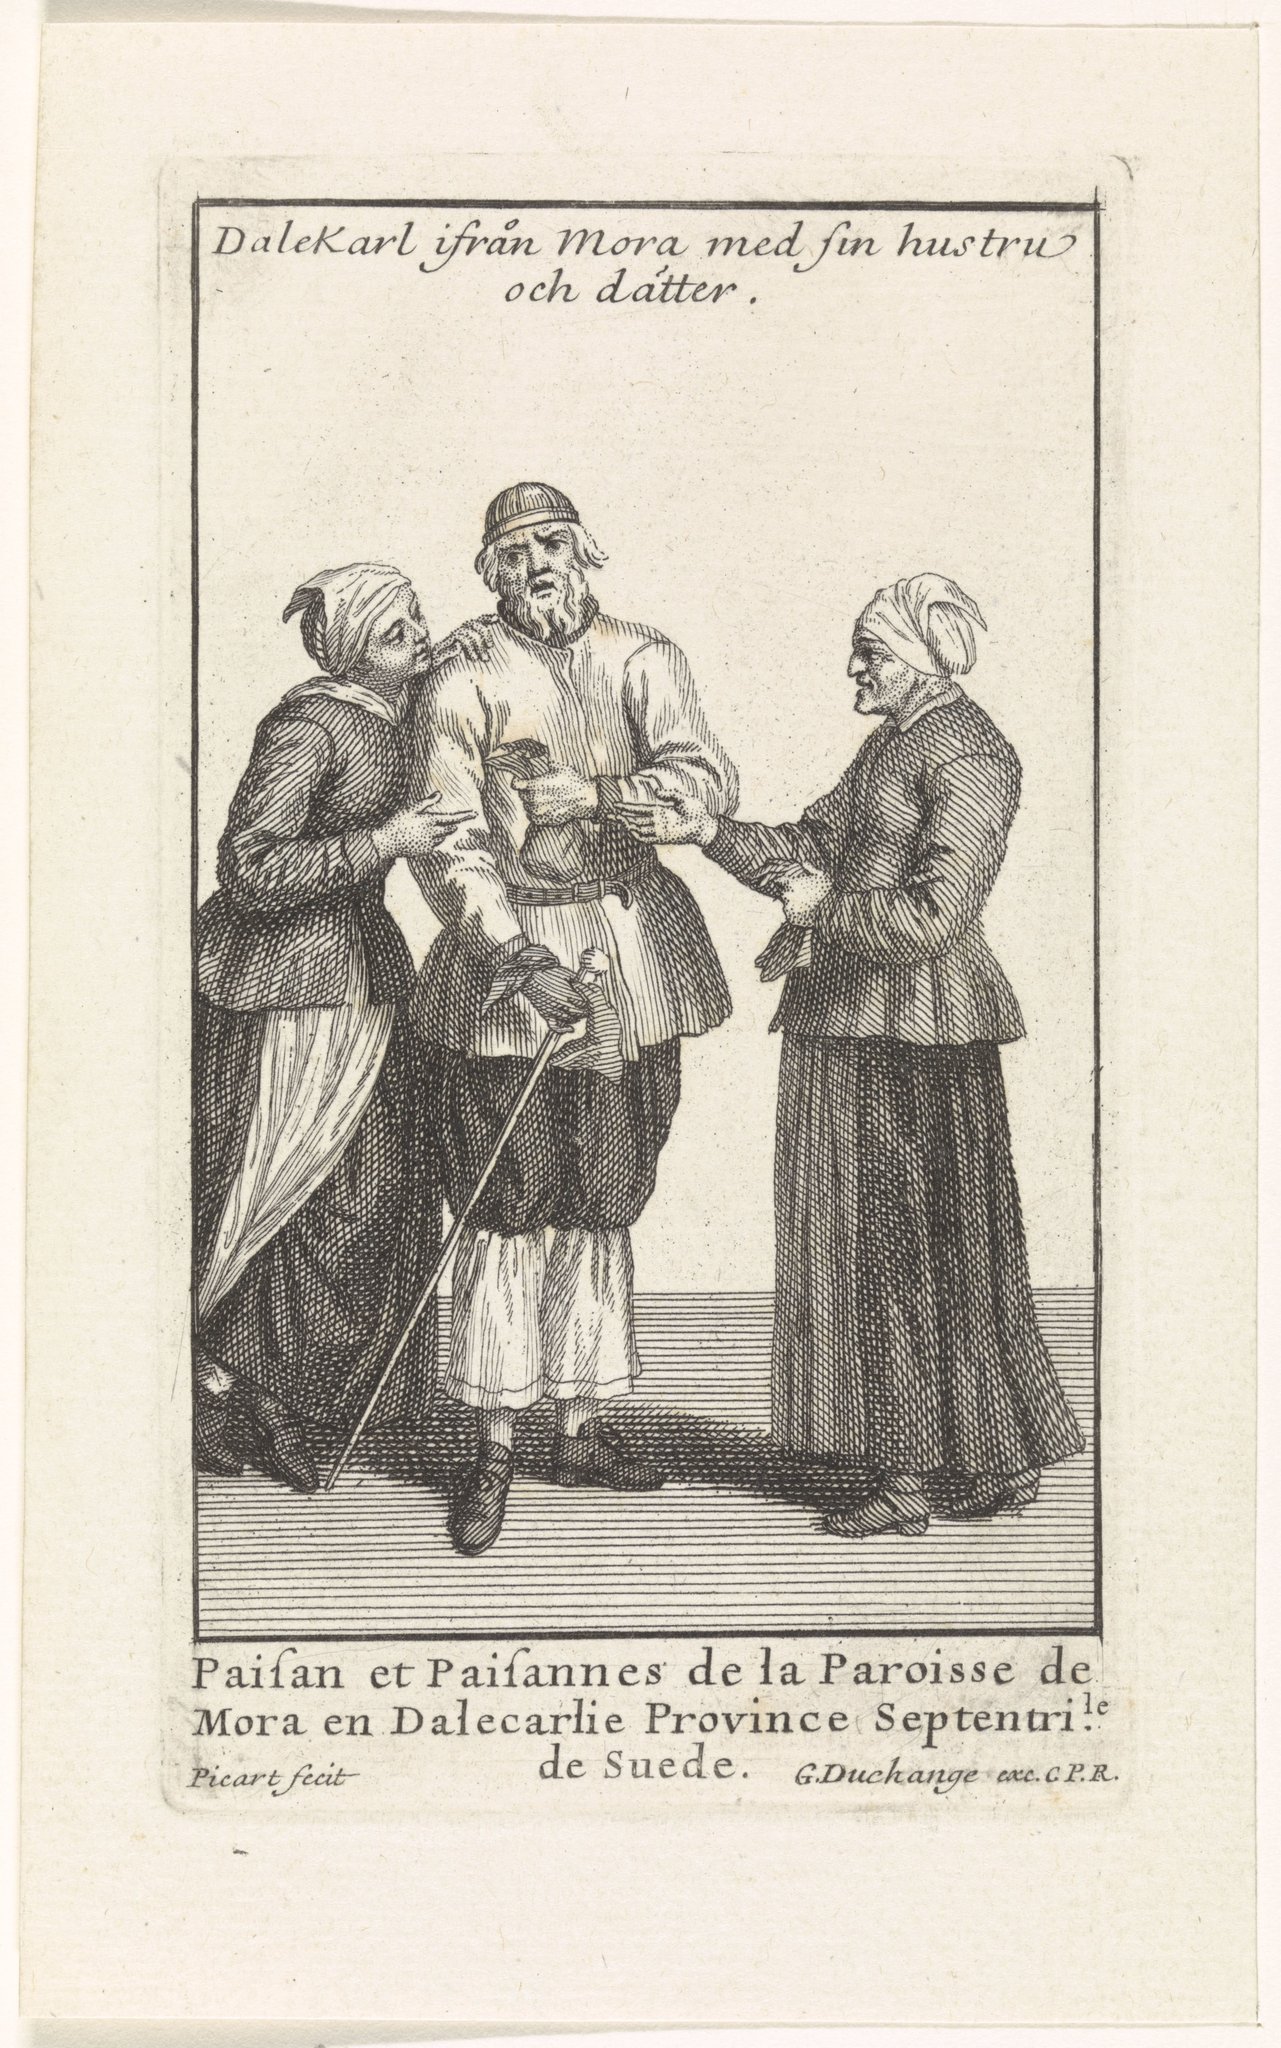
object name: costume print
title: Zweedse kostuums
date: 1704-1707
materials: paper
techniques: engraving, etching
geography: paris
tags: europeans (with name) (+ costume), farmers, clothes, costume (+ women's clothes), clothes, costume (+ men's clothes)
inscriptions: collector's mark: Lugt 240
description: Figuren in klederdracht. De prent heeft een titel in het Zweeds en een onderschrift in het Frans.